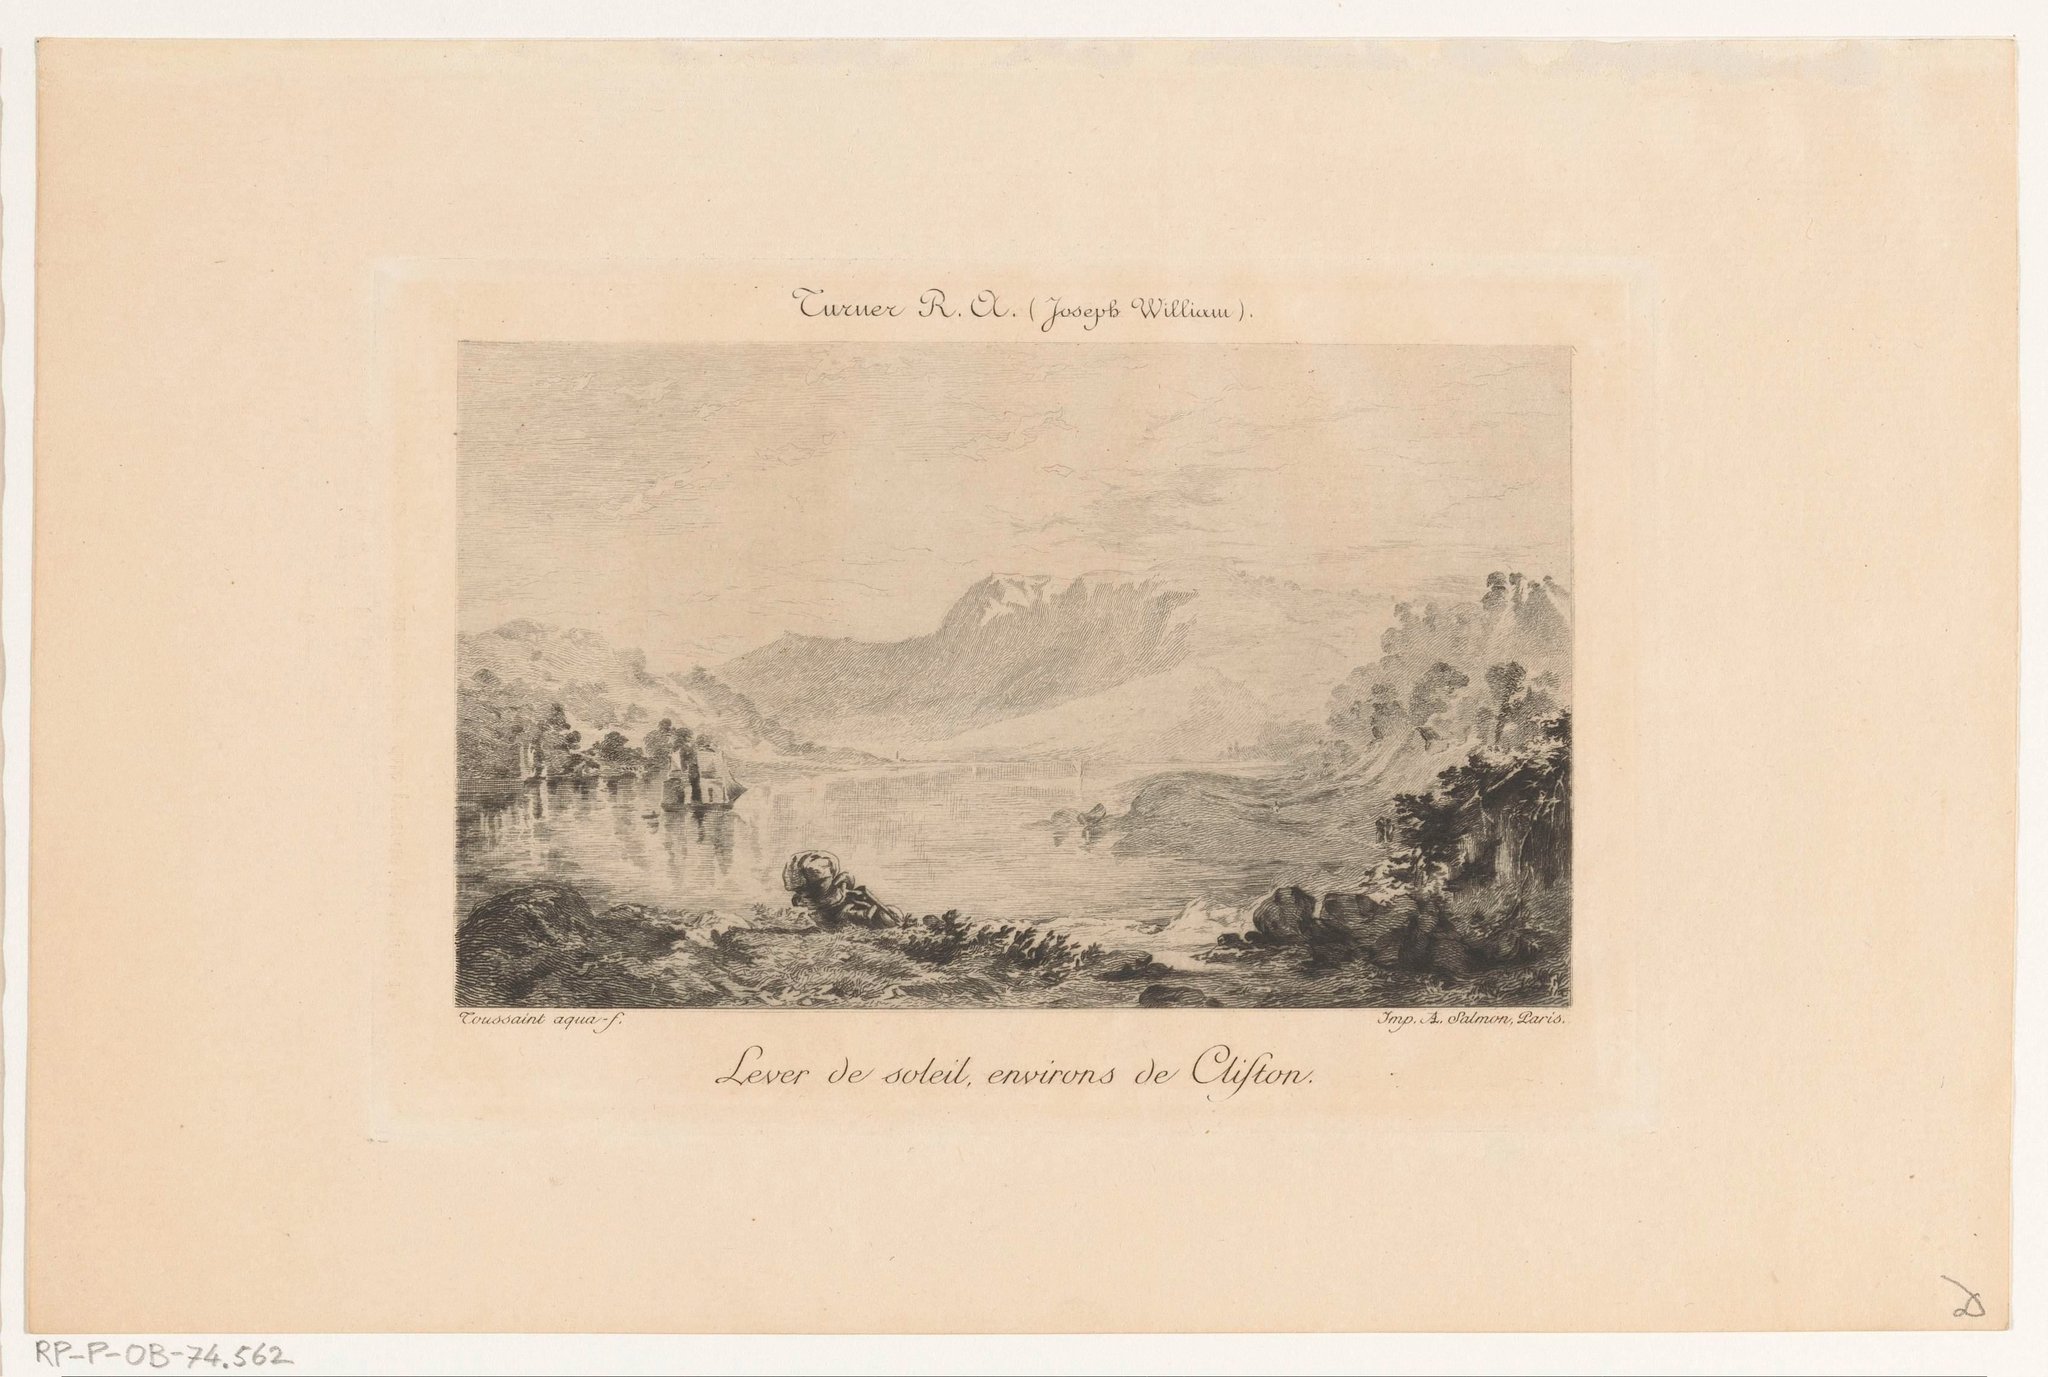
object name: print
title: Lever de soleil, environs de Clifton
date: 1881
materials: paper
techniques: etching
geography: paris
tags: river, mountains - hh - ideal landscapes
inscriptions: collector's mark: Lugt 2228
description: Prent afkomstig uit een veilingcatalogus: "Catalogue des Tableaux anciens composant la très importante collection de Monsieur le Baron de Beurnonville", uitgegeven in 1881 te Parijs door Pillet en Dumoulin. De veiling vond plaats op 9 tot en met 14 en 16 mei 1881.